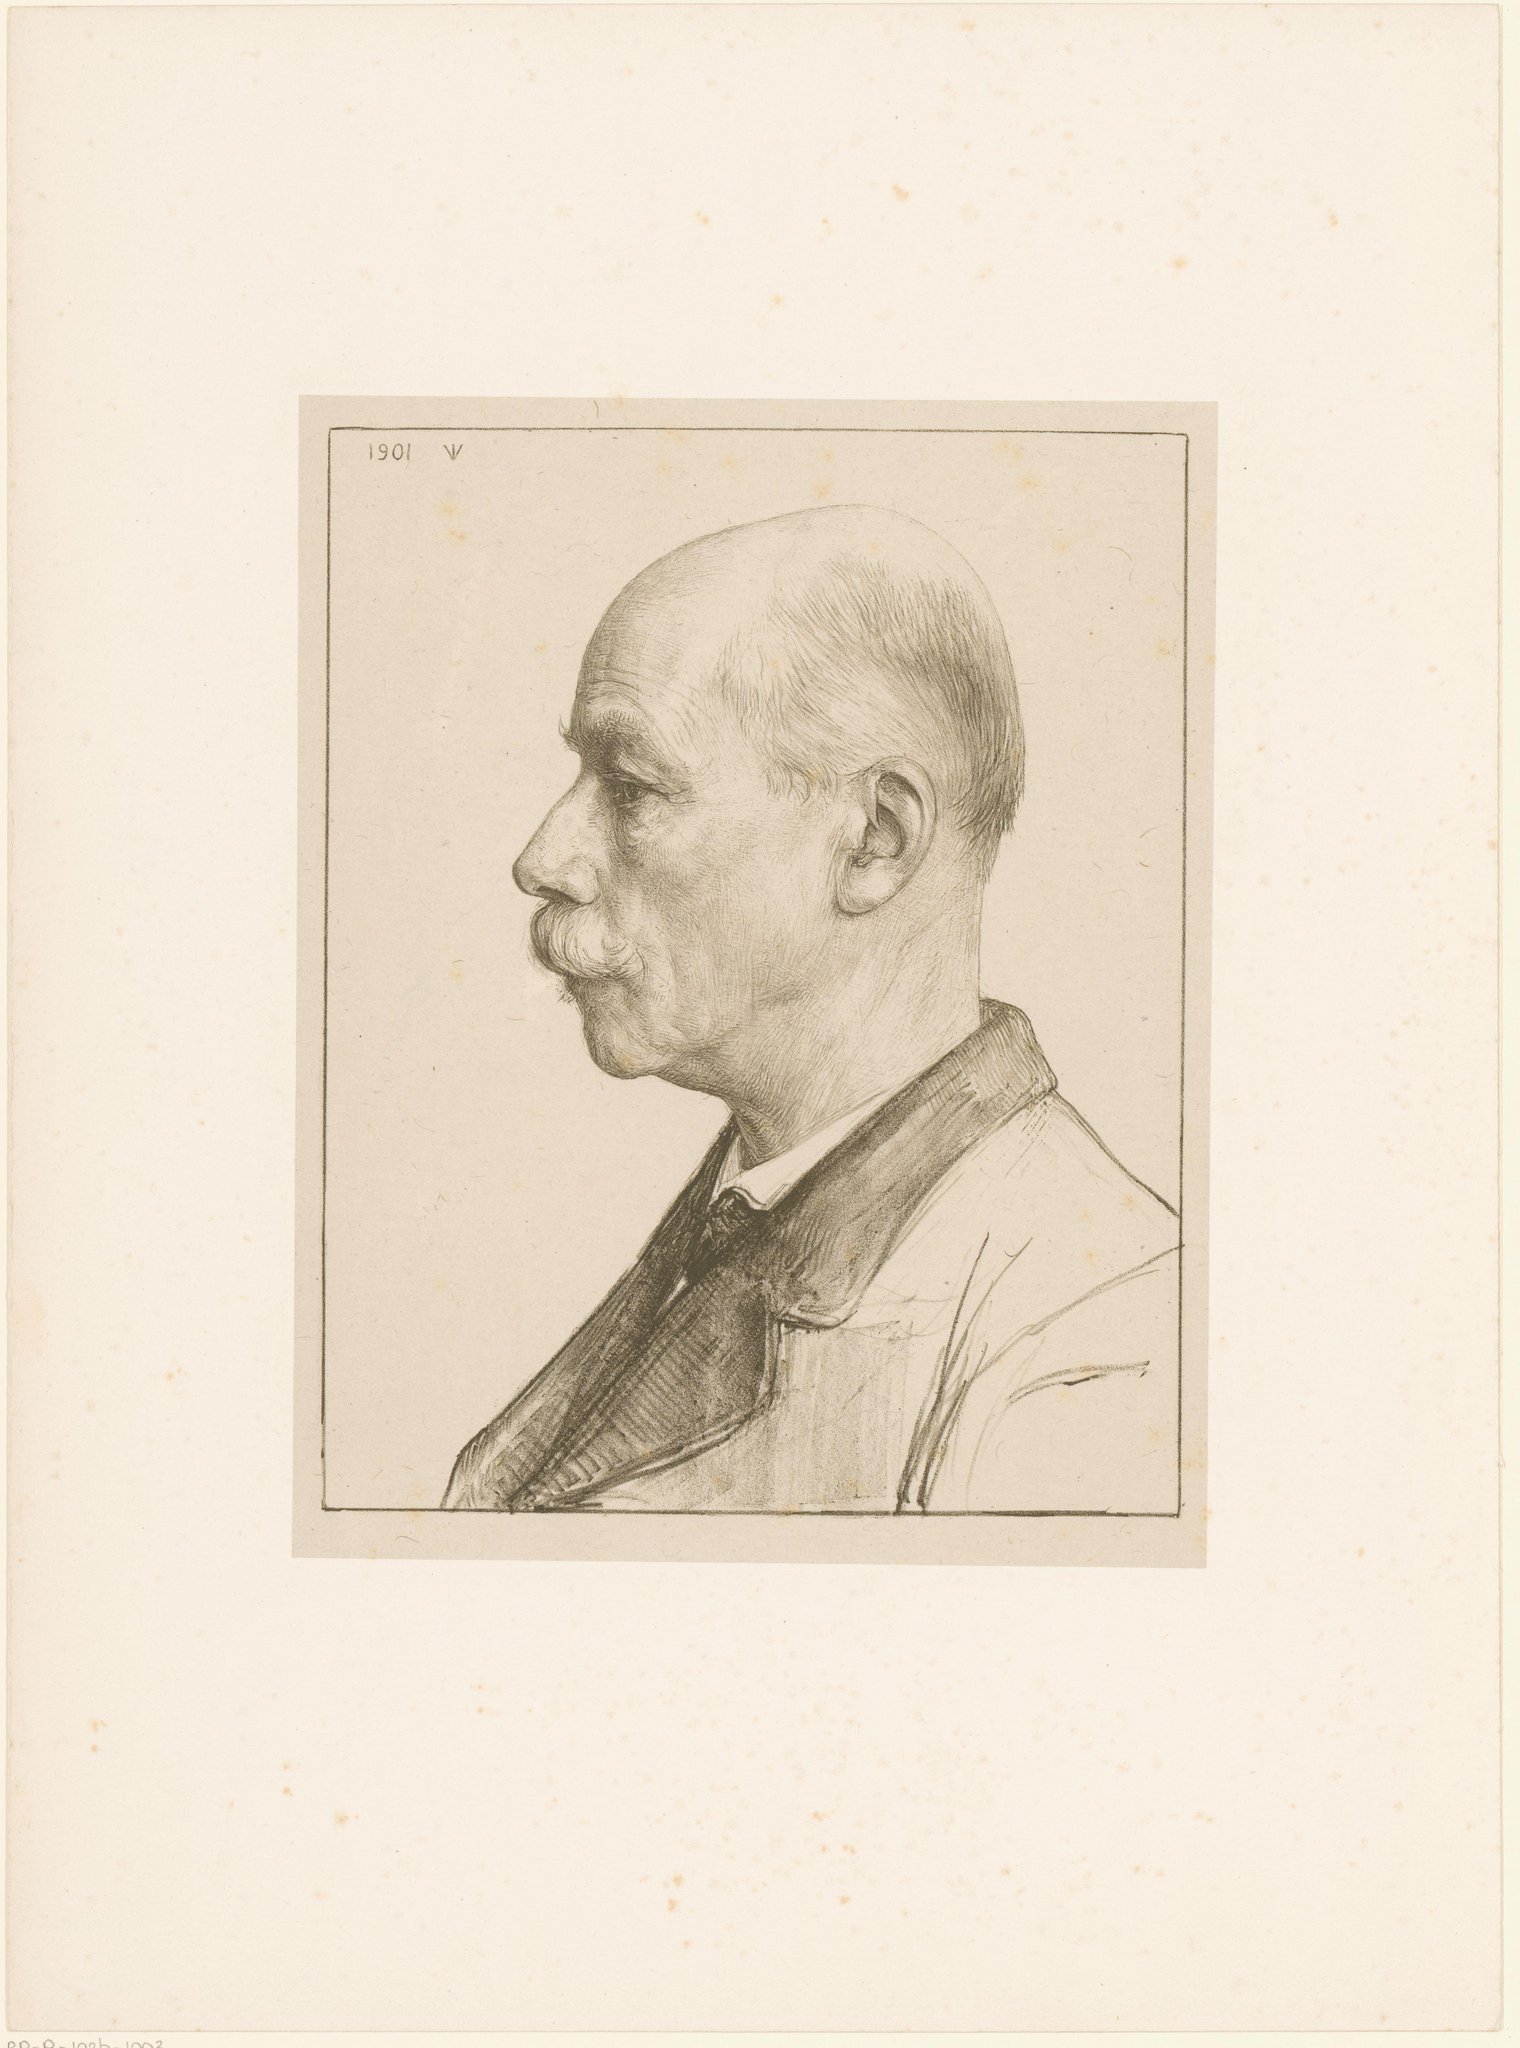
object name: print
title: Portret van J.H. Schorer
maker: jan veth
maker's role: designer, draughtsman, painter, print maker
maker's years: 1864-1925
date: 1901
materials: paper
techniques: lithograph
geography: netherlands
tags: publisher, j.h. schorer, historical persons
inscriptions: collector's mark: Lugt 2228, collector's mark: ‘H.G. Samson Amsterdam’